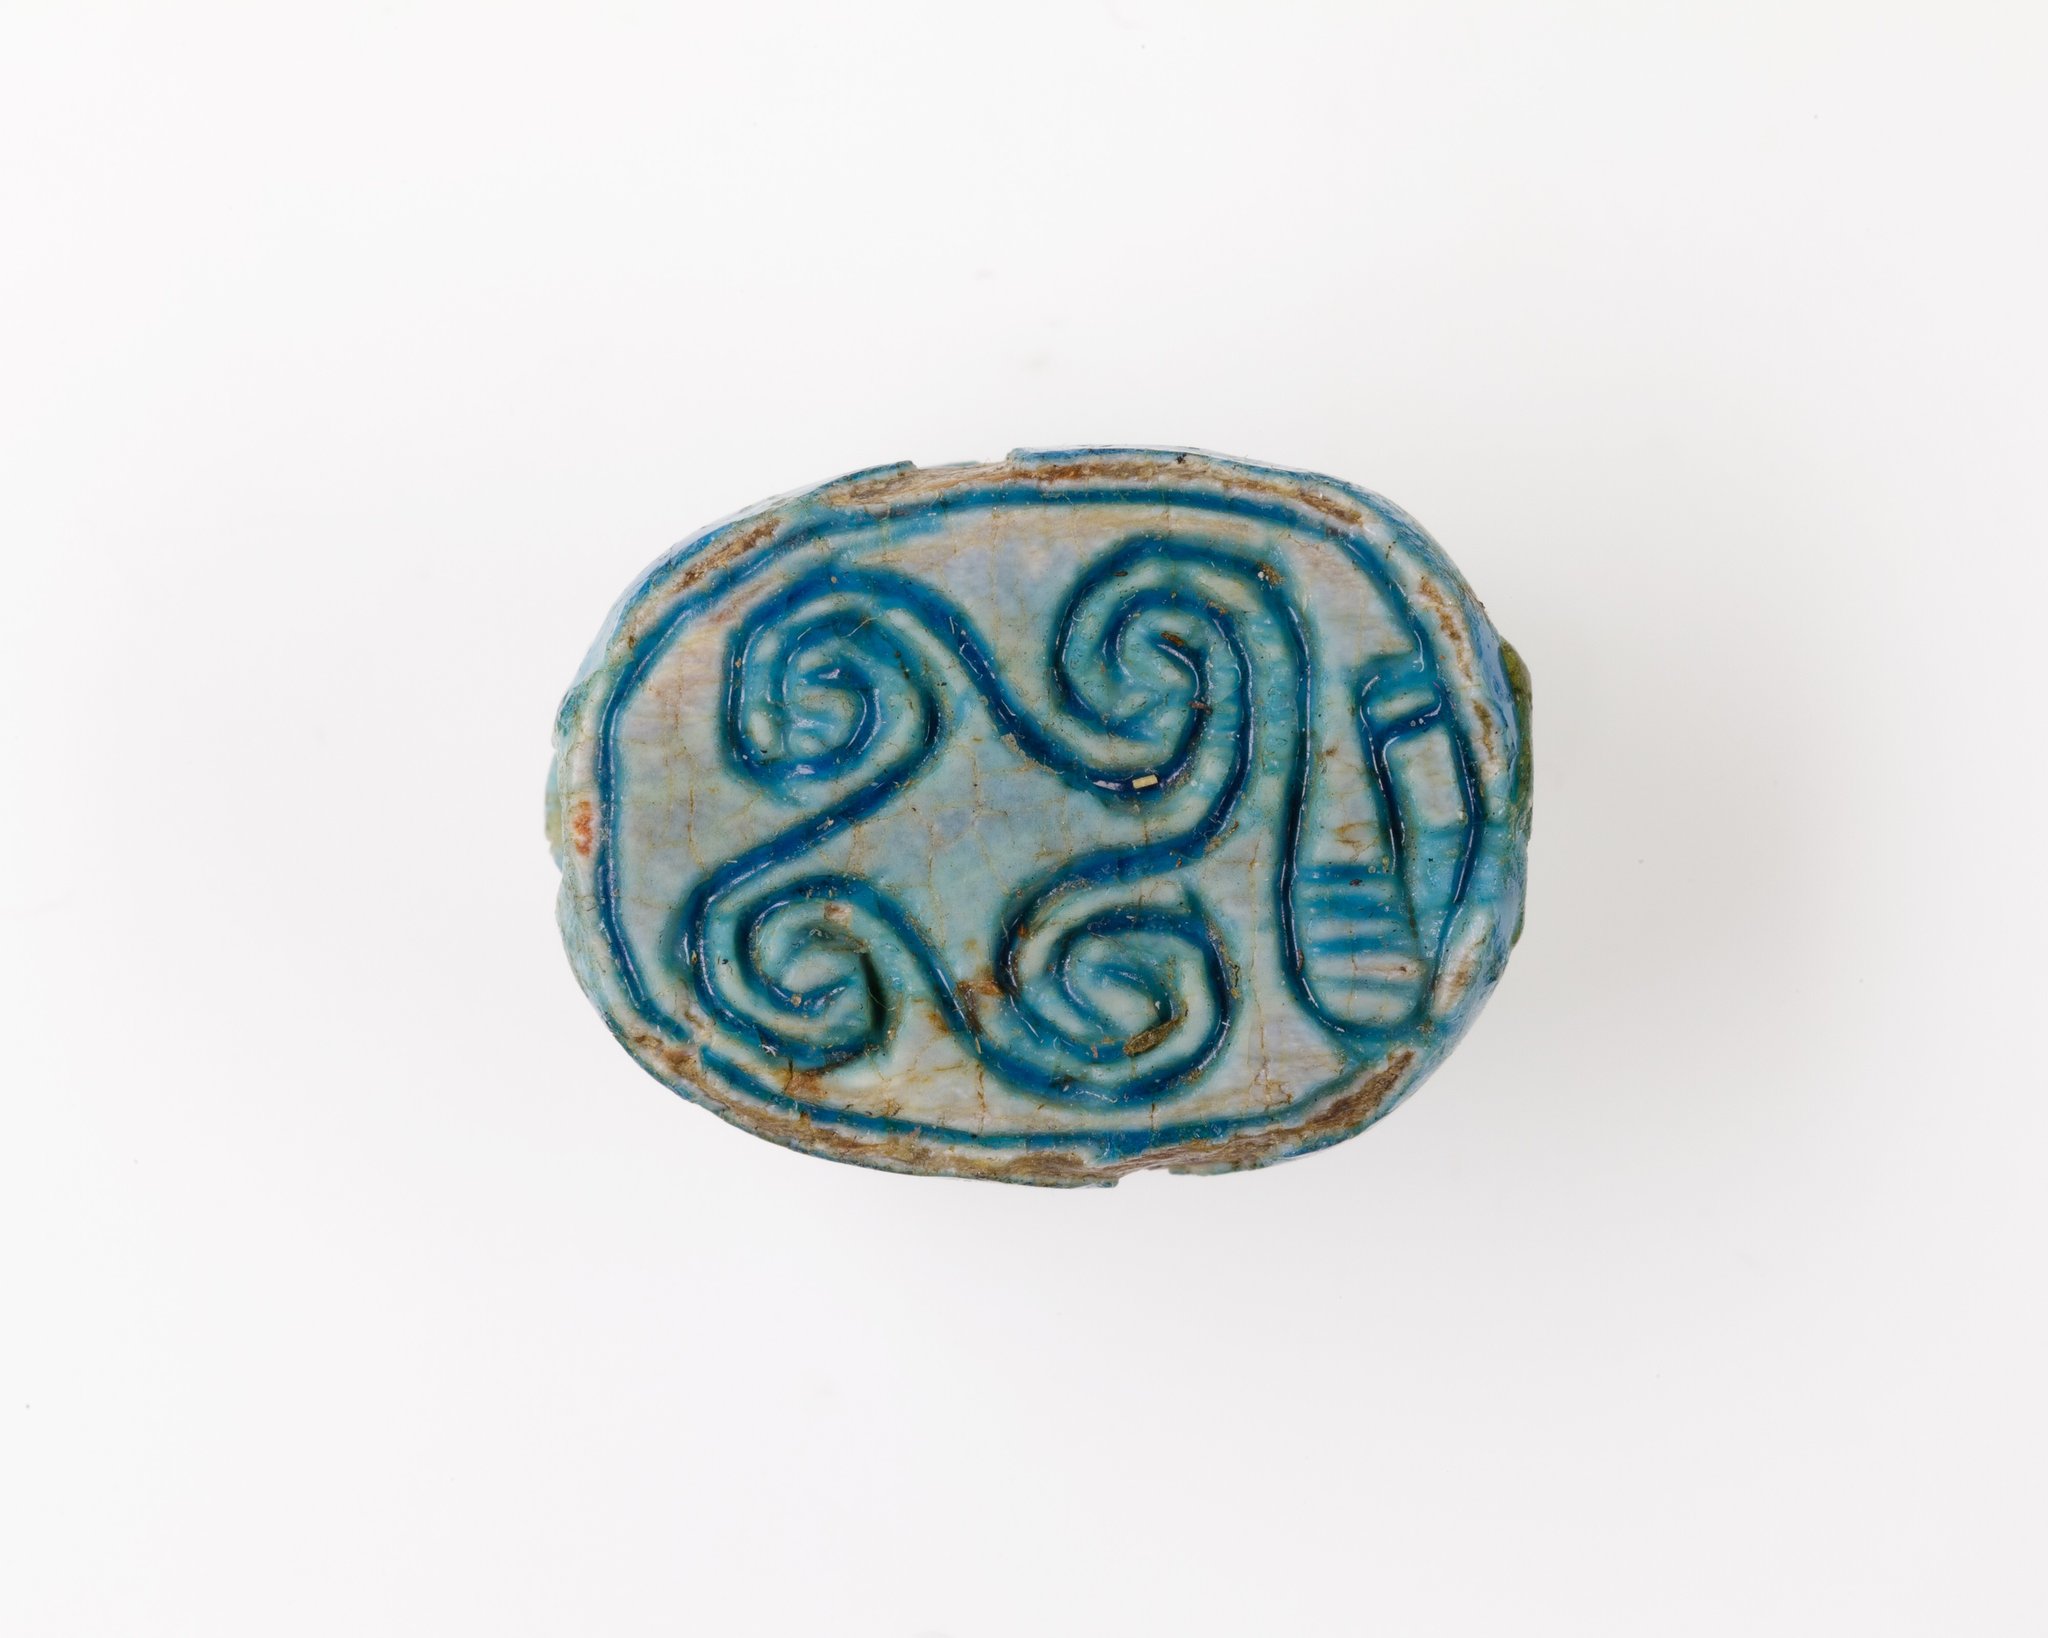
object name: scarab, papyrus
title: Scarab Decorated with Scrolls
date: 1740-1640 BCE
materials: stone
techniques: glazing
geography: egypt